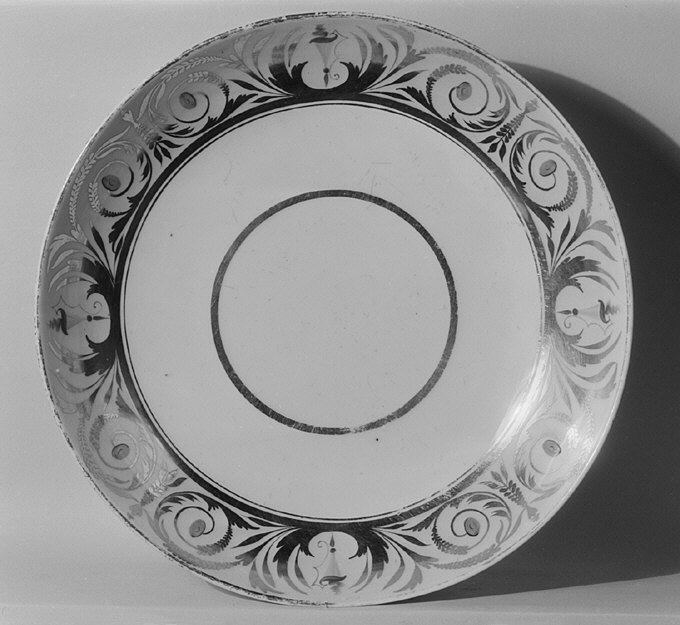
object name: plate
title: Plate (part of a service)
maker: derby porcelain manufactory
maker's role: factory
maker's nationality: british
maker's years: 1751-1785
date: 1801-1900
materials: soft paste porcelain